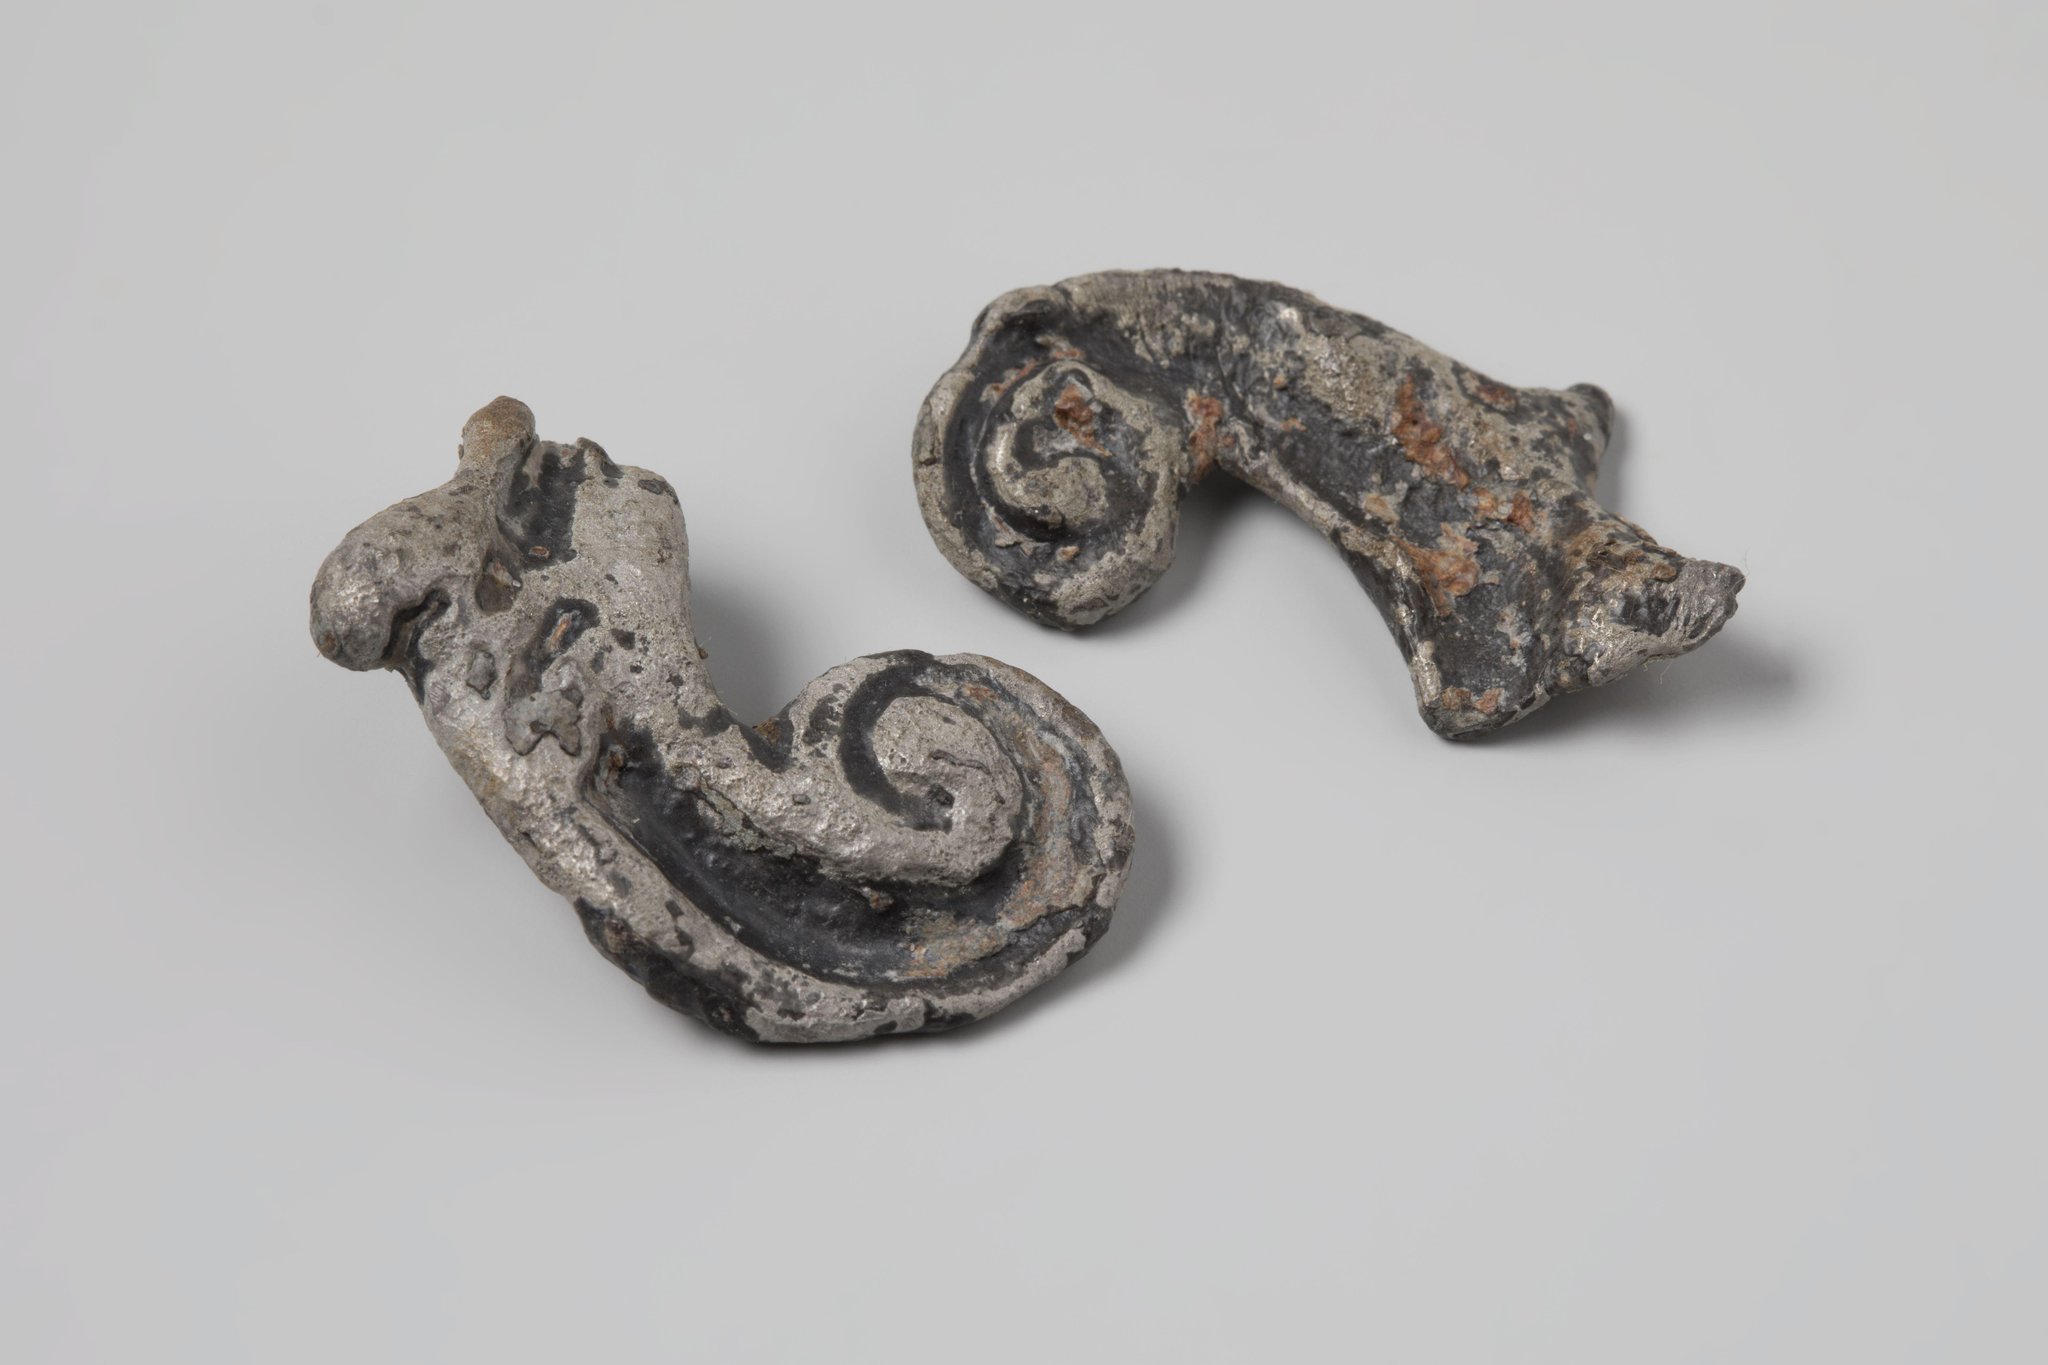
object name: beslag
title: Decoratief beslag uit het wrak van de Oost-Indiëvaarder Hollandia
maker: Anonymous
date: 1700-1743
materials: lead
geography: netherlands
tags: verenigde oostindische compagnie, hollandia (schip), annet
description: Fitting, decorative fitting or fragment; fragm, id. NG 1980-27H1749, eroded.